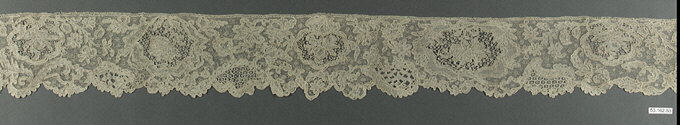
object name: border and lappet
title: Matching border to pair of lappets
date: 1701-1800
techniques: lace